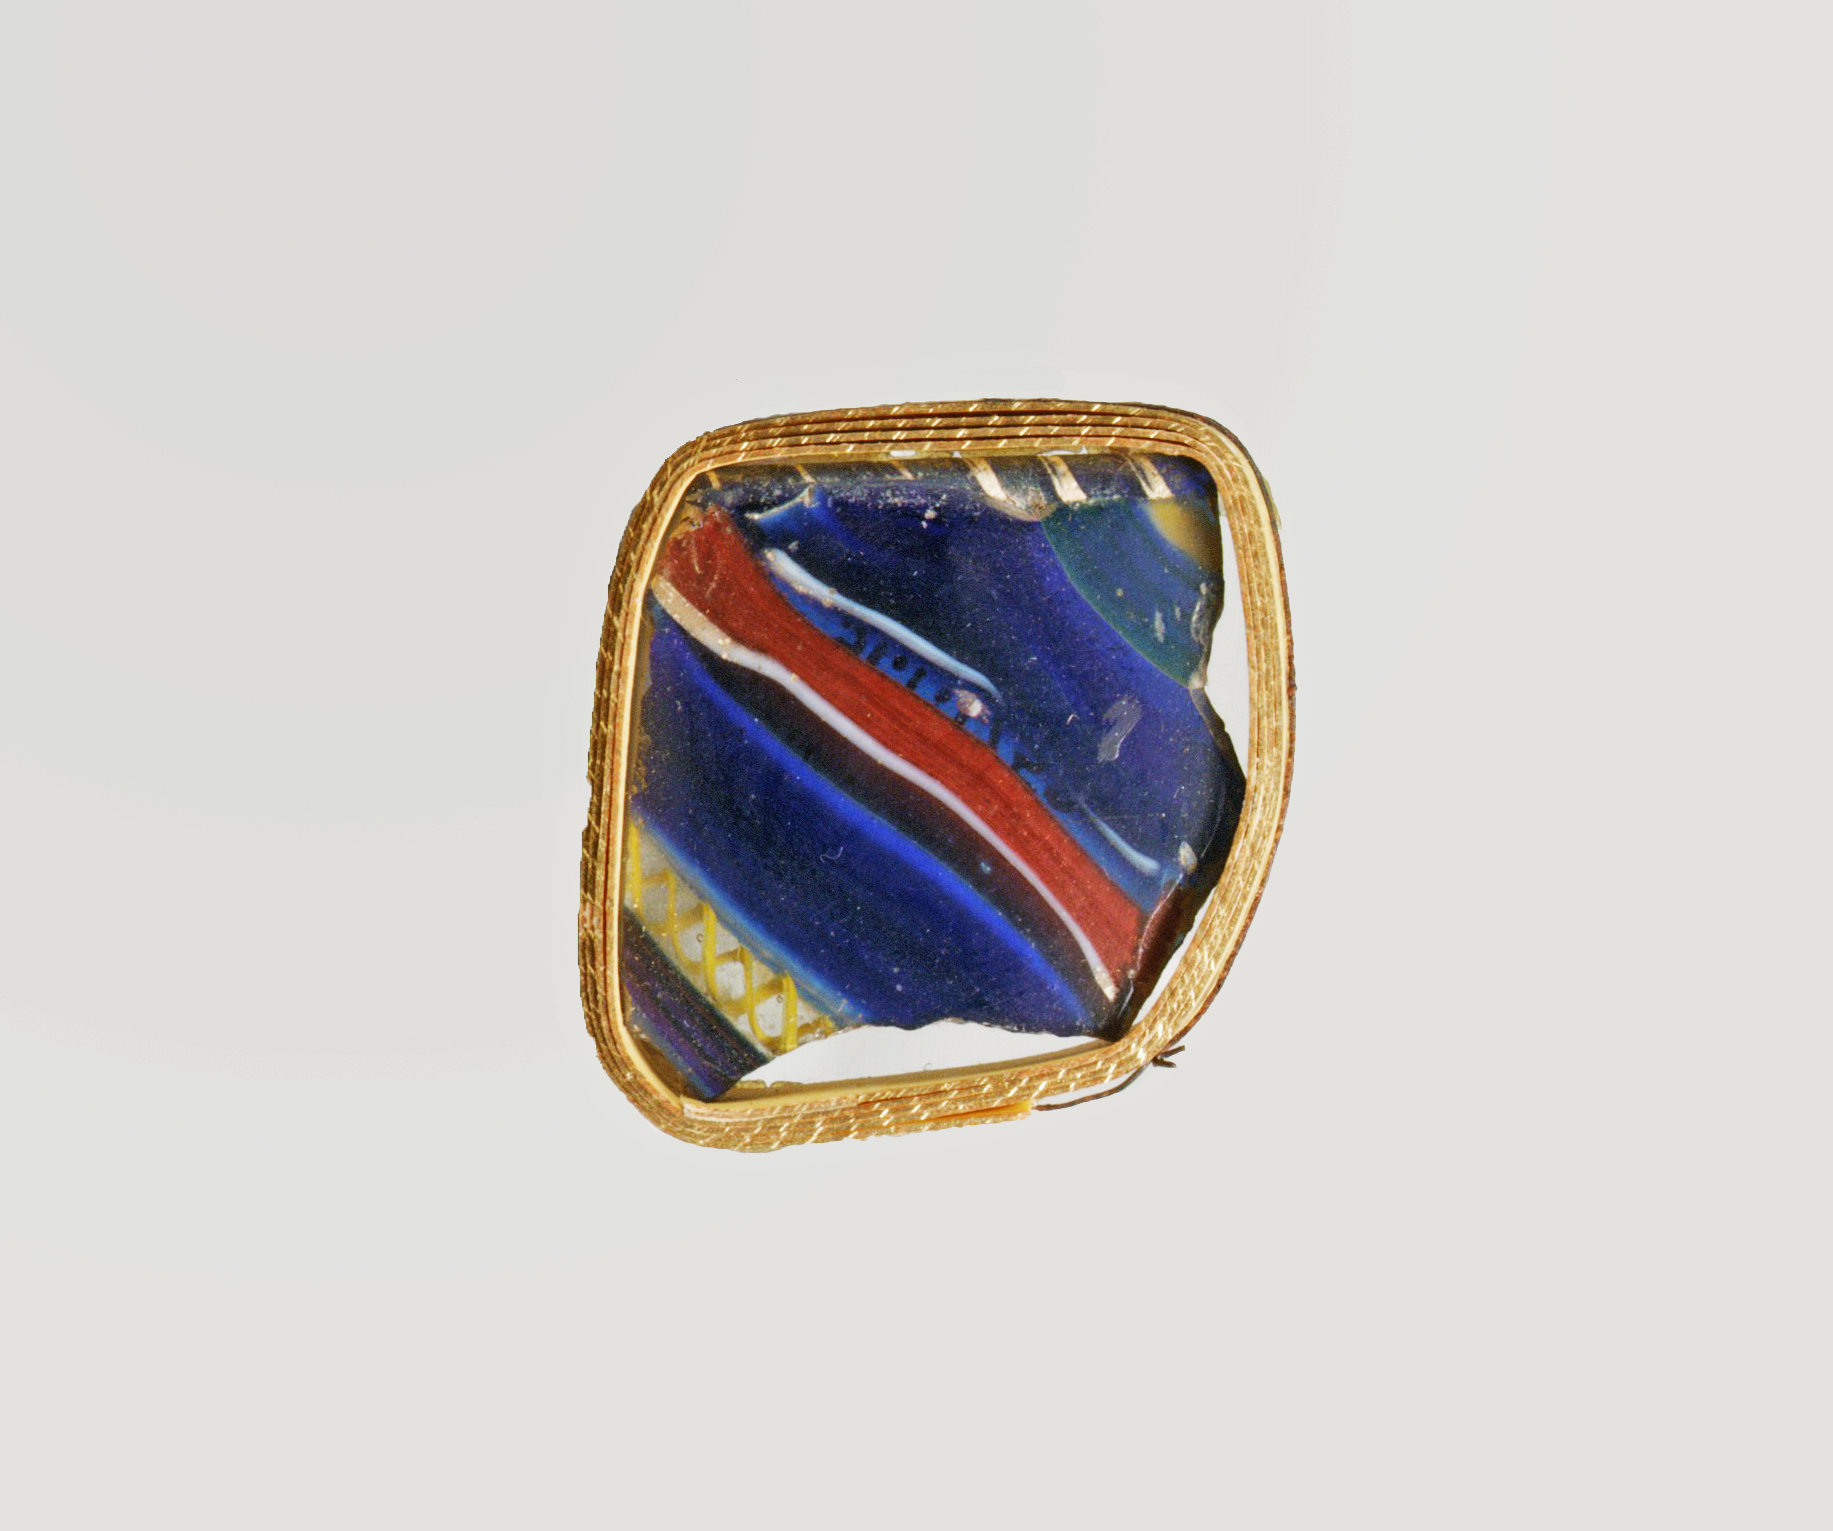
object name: fragment, striped mosaic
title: Glass striped mosaic bowl fragment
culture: roman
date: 34 BCE-33 CE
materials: glass